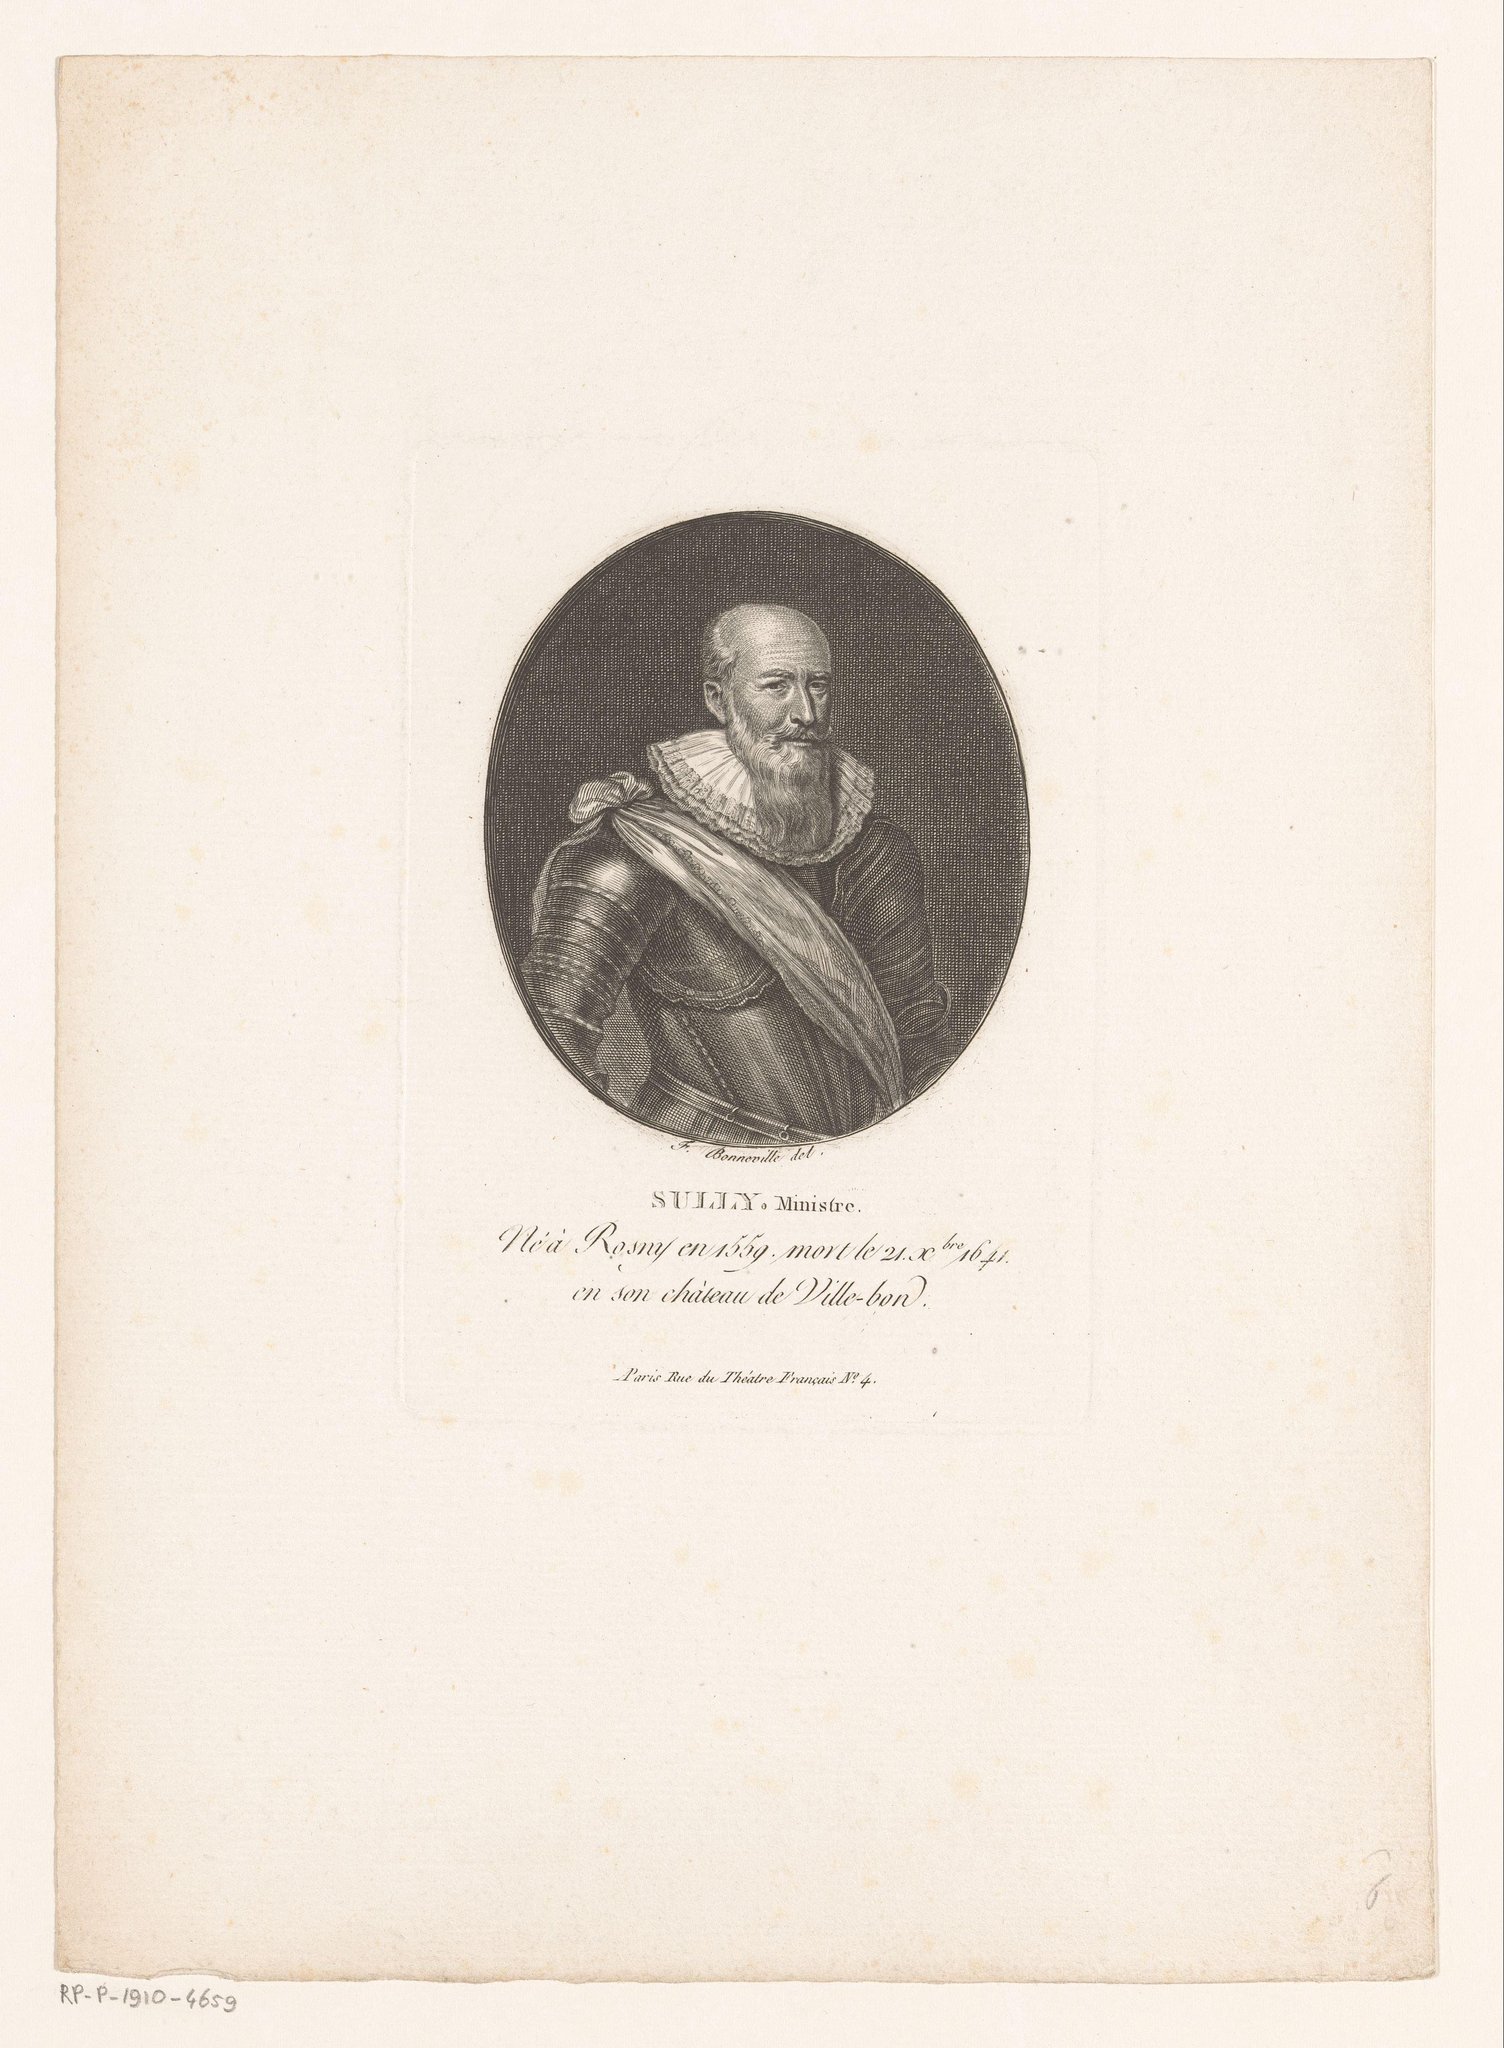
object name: print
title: Portret van Maximilien de Bethune, hertog van Sully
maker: françois bonneville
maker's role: draughtsman, painter, print maker, publisher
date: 1796-1802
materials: paper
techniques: engraving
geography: paris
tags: maximilien de béthune (duke of sully), armour, historical persons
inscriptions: collector's mark: Lugt 2228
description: Maakt deel uit van een serie getiteld: Portraits des personnages célèbres de la Révolution (...), uitgegeven tussen 1796-1802.